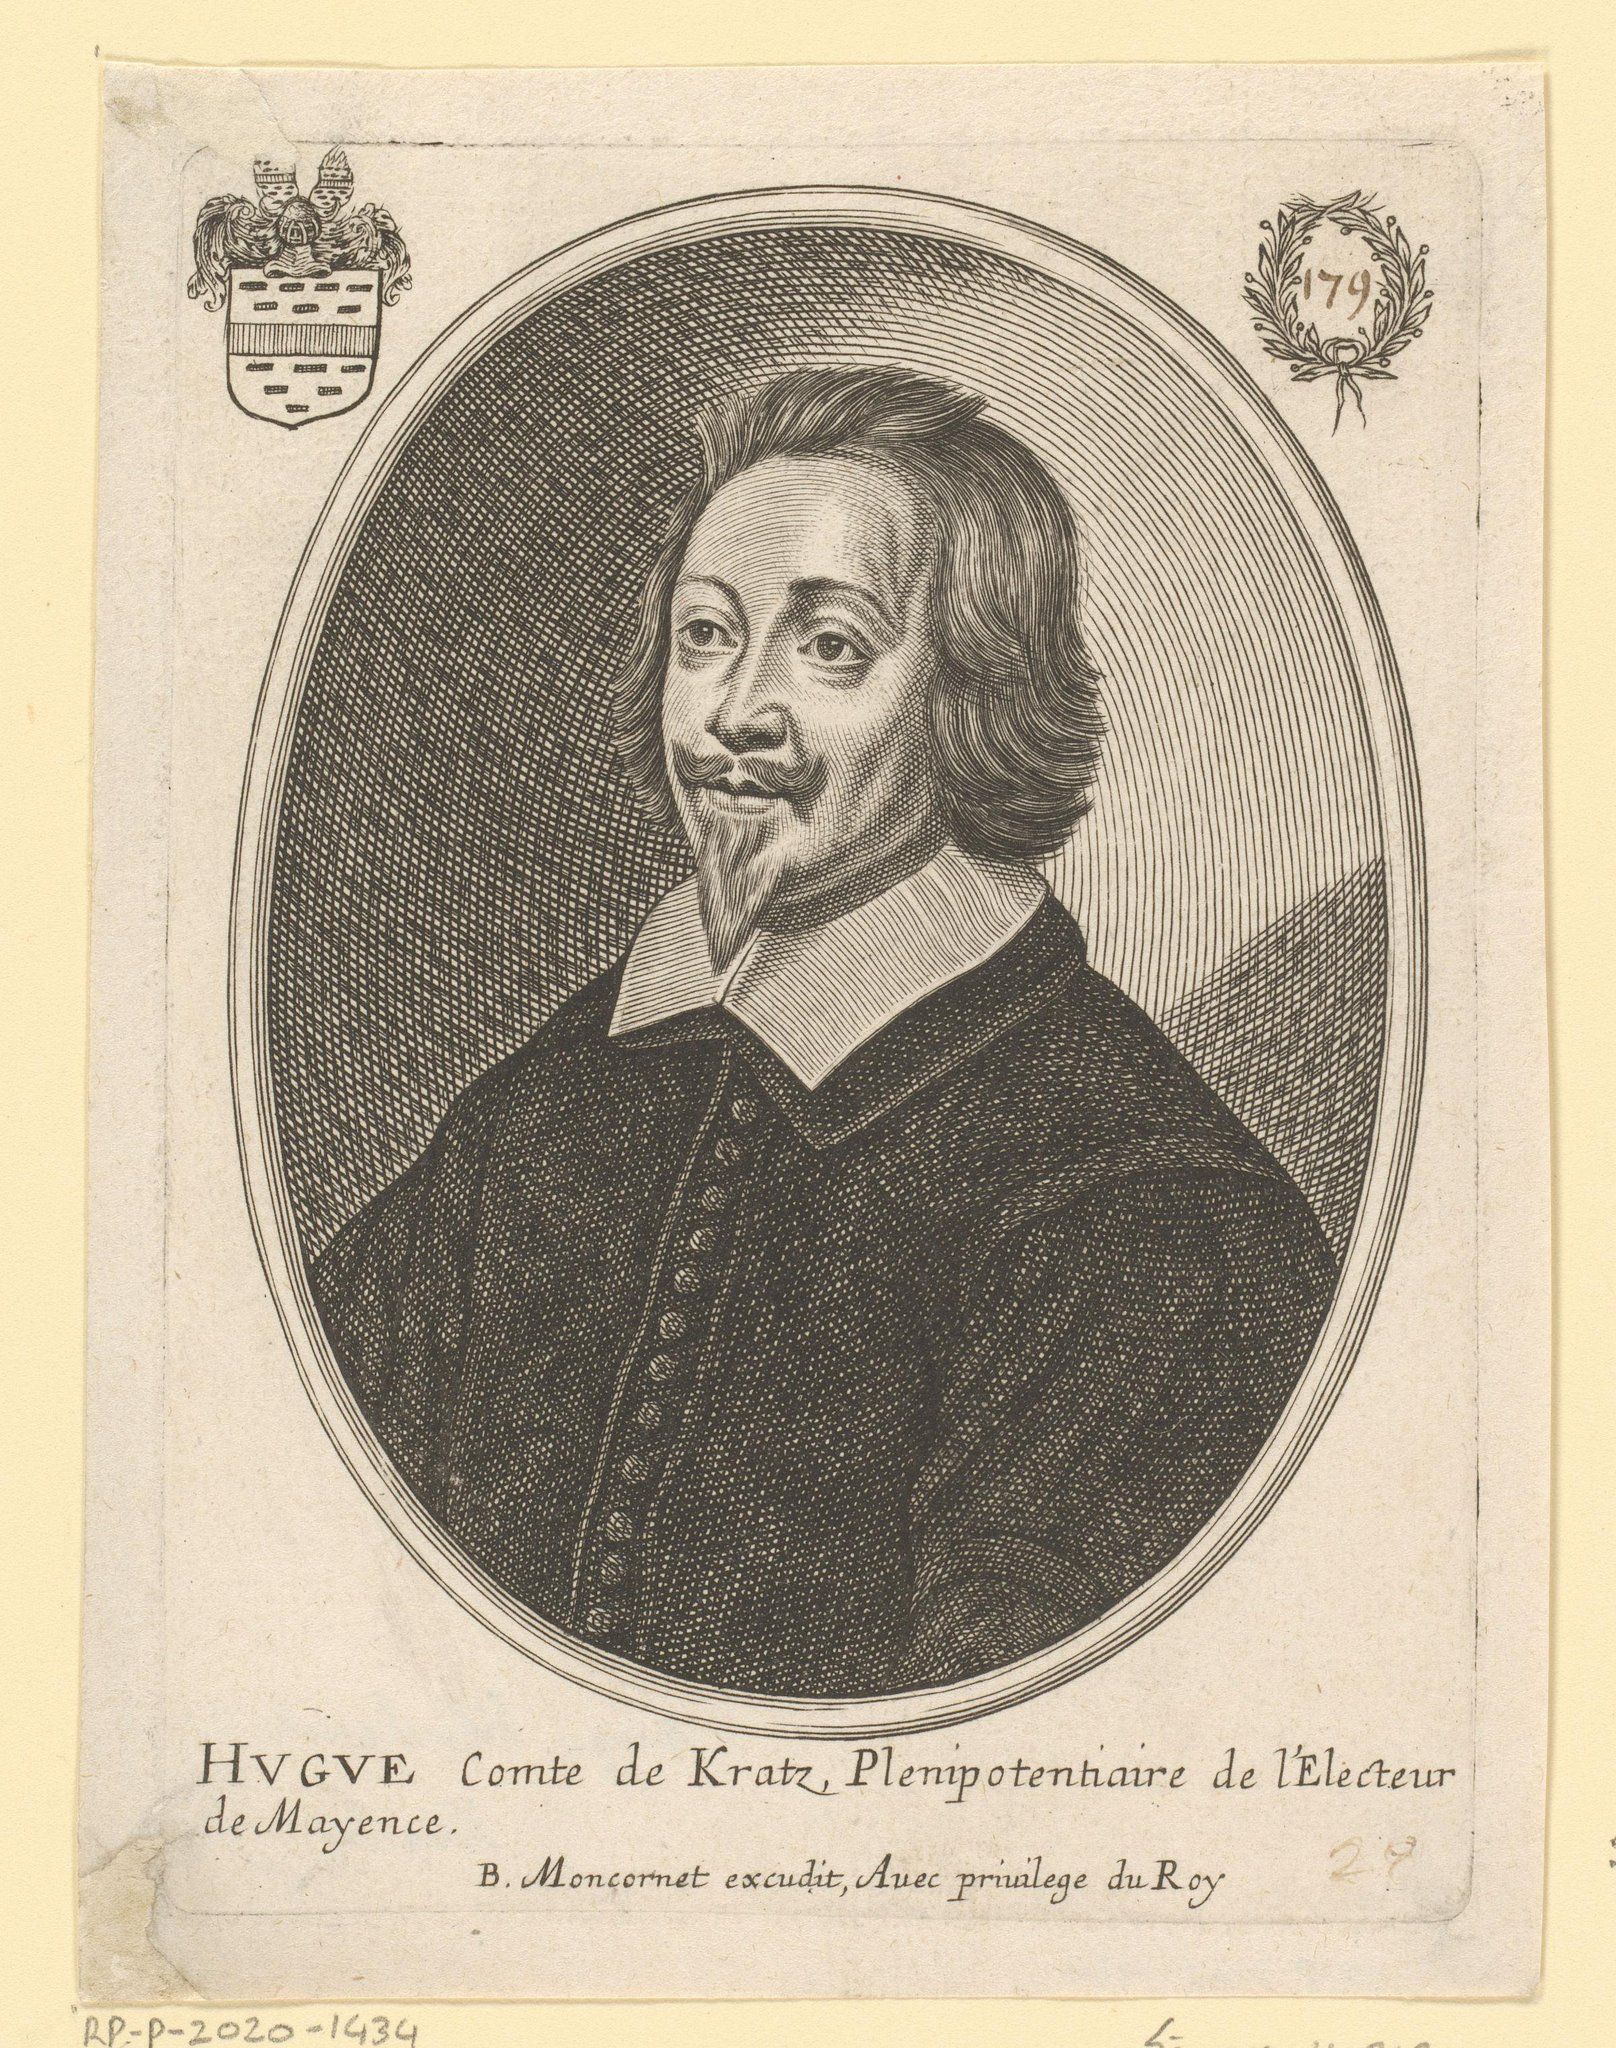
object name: print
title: Portret van Hugo Everhard Cratz, graaf van Scharfenstein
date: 1645-1668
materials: paper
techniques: engraving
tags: archbishop, bishop, etc. (roman catholic), historical persons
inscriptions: inscription: ‘179’, inscription: ‘2[...]’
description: De prent is waarschijnlijk een proefdruk van een prent die deel uit maakt van een serie van 35 prenten met portretten van de ambassadeurs van de Vrede van Westfalen.